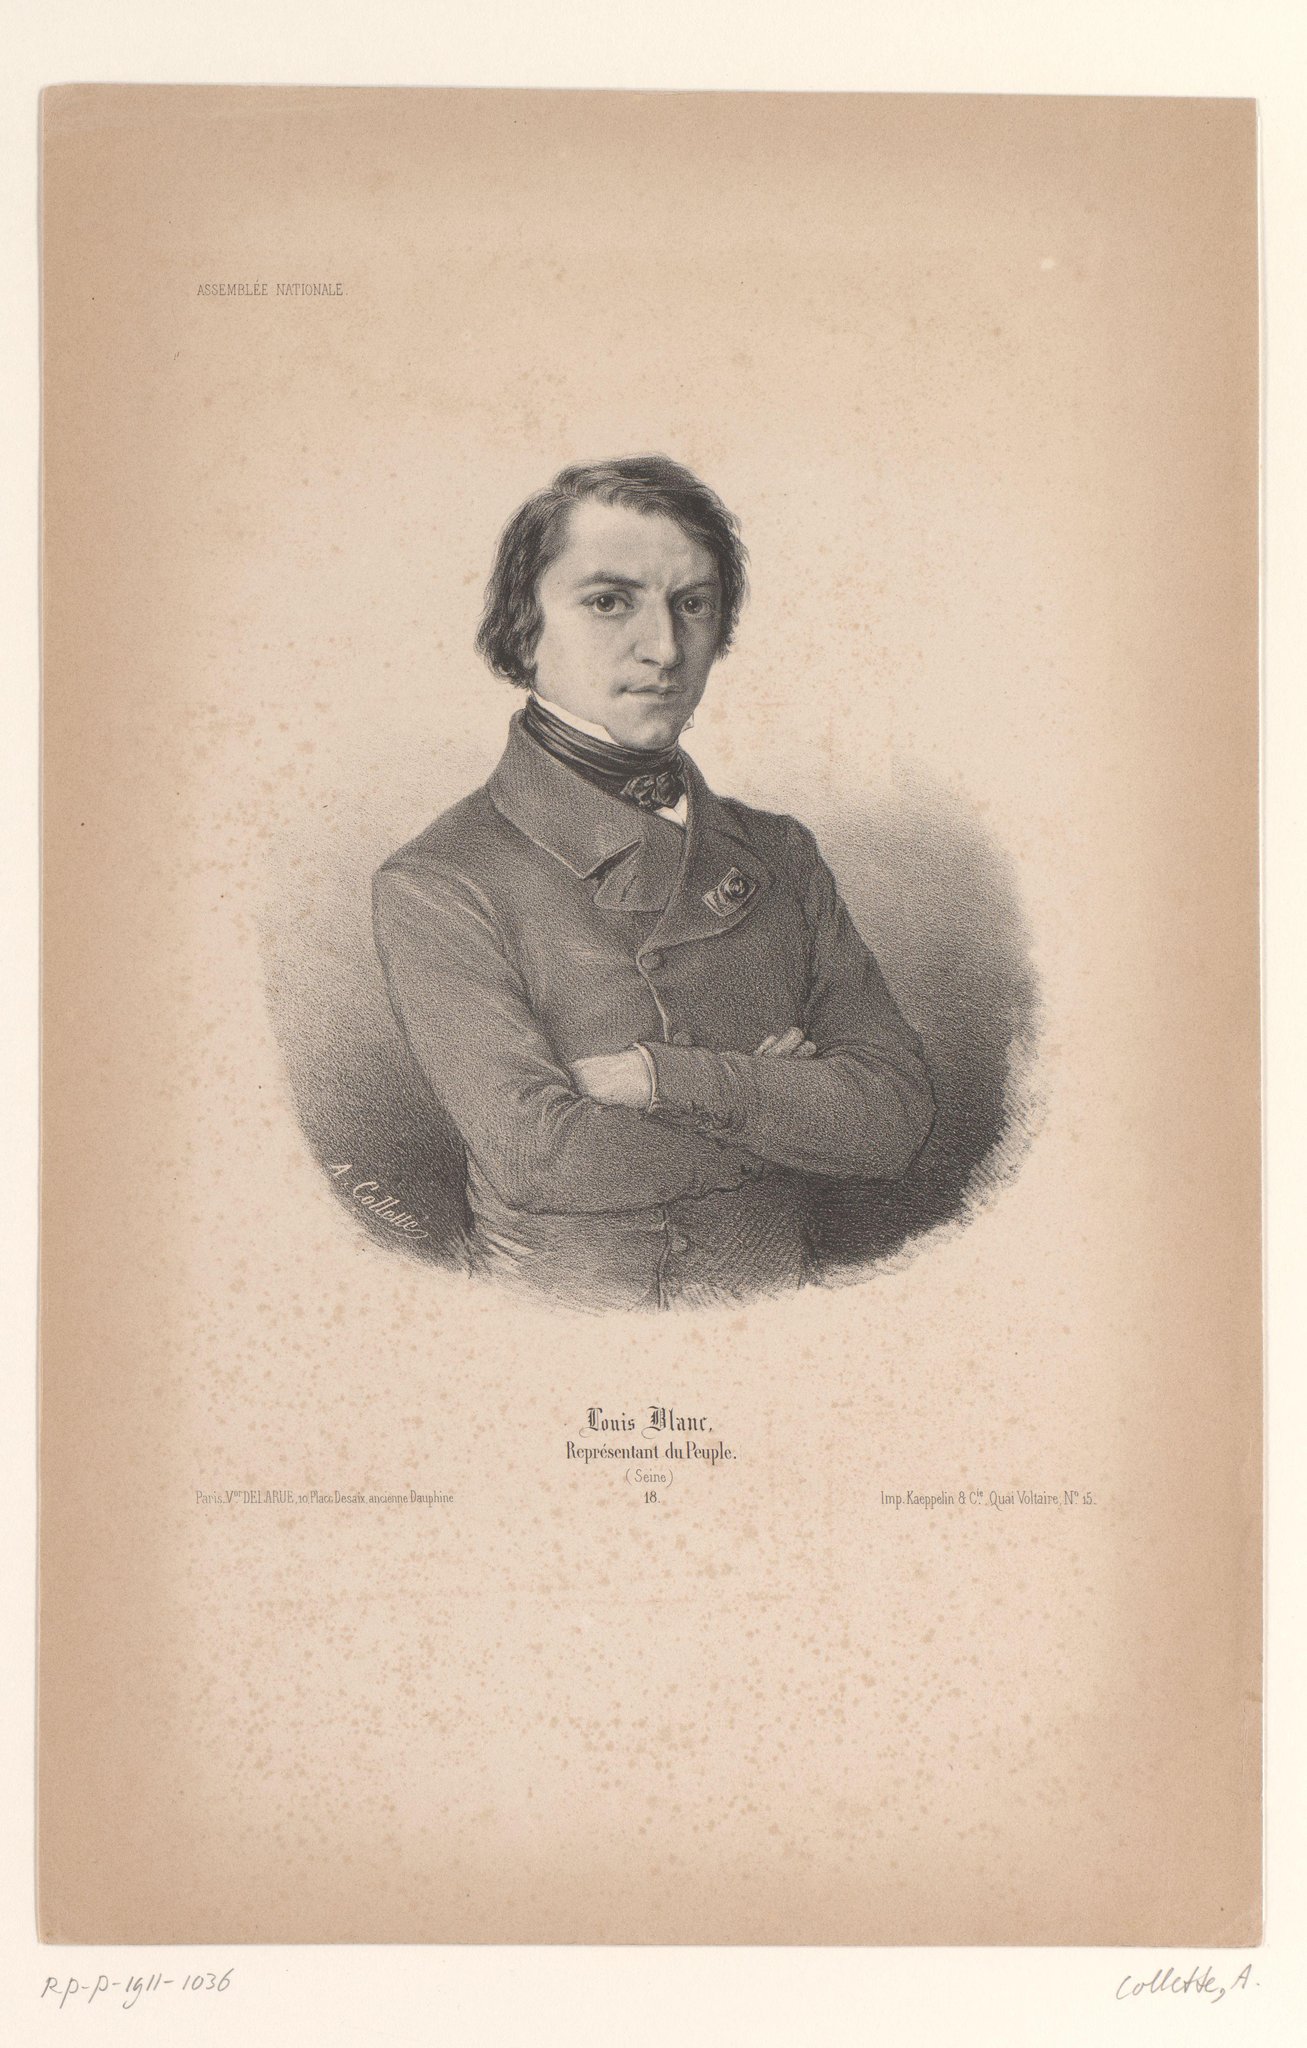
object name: print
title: Assemblée Nationale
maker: alexandre collette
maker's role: print maker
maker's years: 1814-1876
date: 1848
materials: paper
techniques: lithograph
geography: paris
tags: politician, historical persons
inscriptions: collector's mark: Lugt 2228a